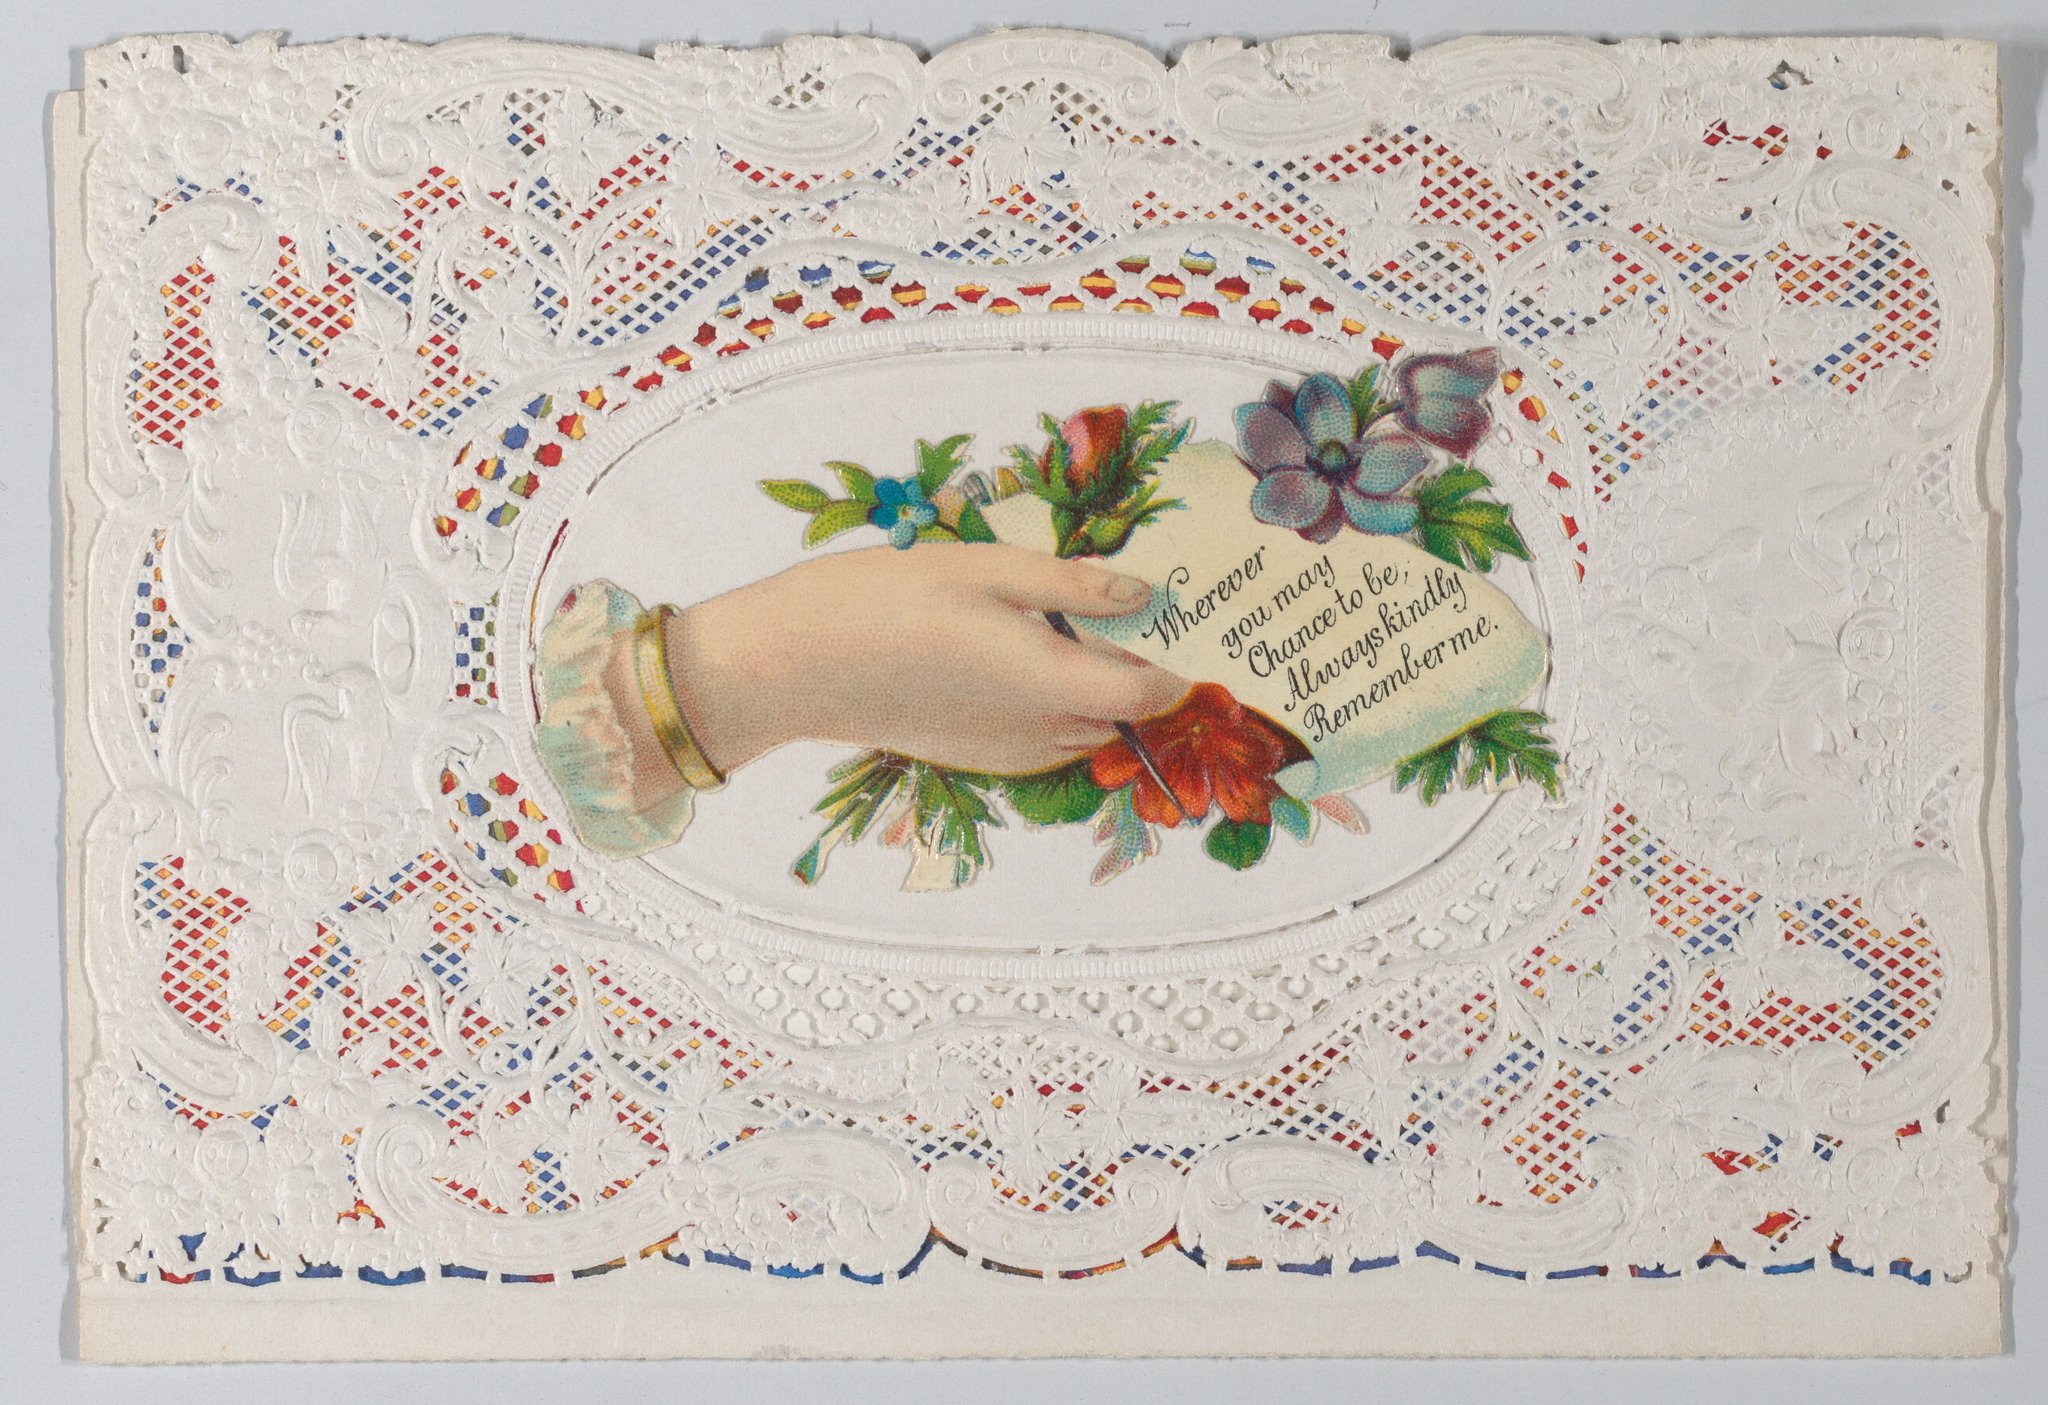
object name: valentine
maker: Anonymous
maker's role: artist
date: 1880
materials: lace, paper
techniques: chromolithography, cutting, embossing, open work